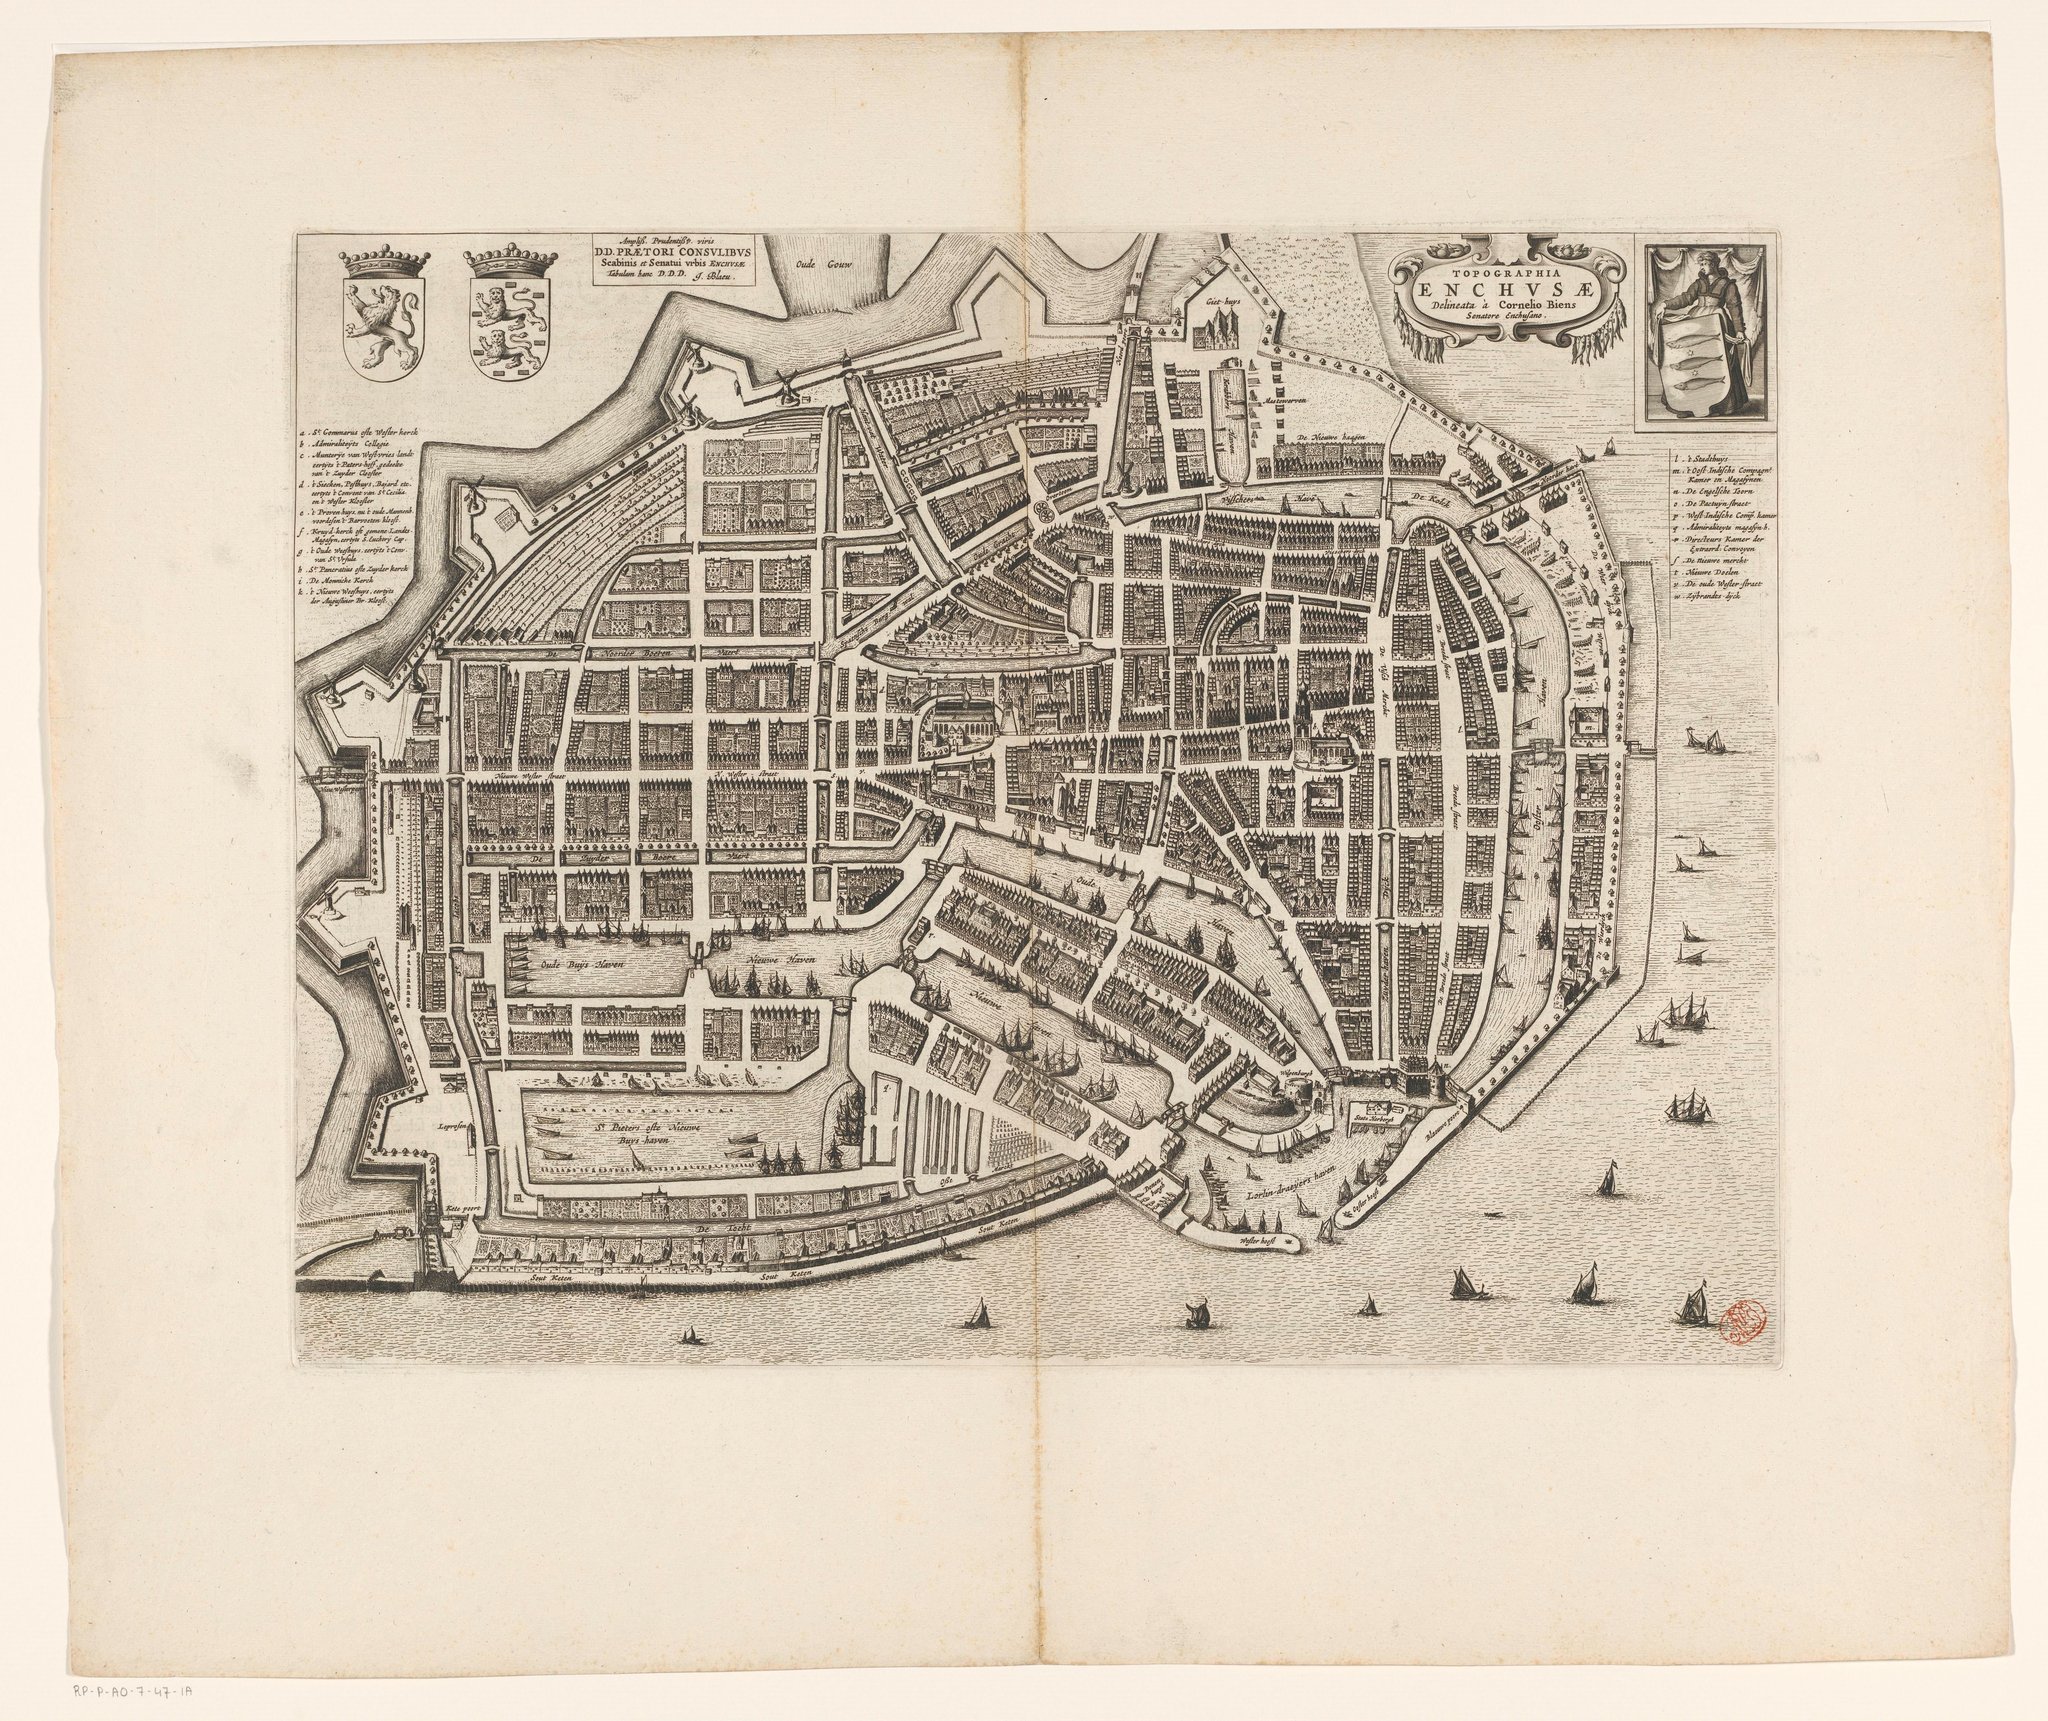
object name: area plan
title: Plattegrond van Enkhuizen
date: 1652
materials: paper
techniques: engraving, etching, letterpress printing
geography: amsterdam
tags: coat of arms (as symbol of the state, etc.), coat of arms (as symbol of the state, etc.) (+ city; municipal), maps of cities, enkhuizen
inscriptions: collector's mark: Lugt 195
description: Plattegrond in vogelvluchtperspectief. Linksboven de wapens van Holland en West-Friesland, daaronder een legenda. Rechtsboven de titelcartouche en het wapen van Enkhuizen. Daaronder nog een legenda. Op verso Nederlandse tekst.